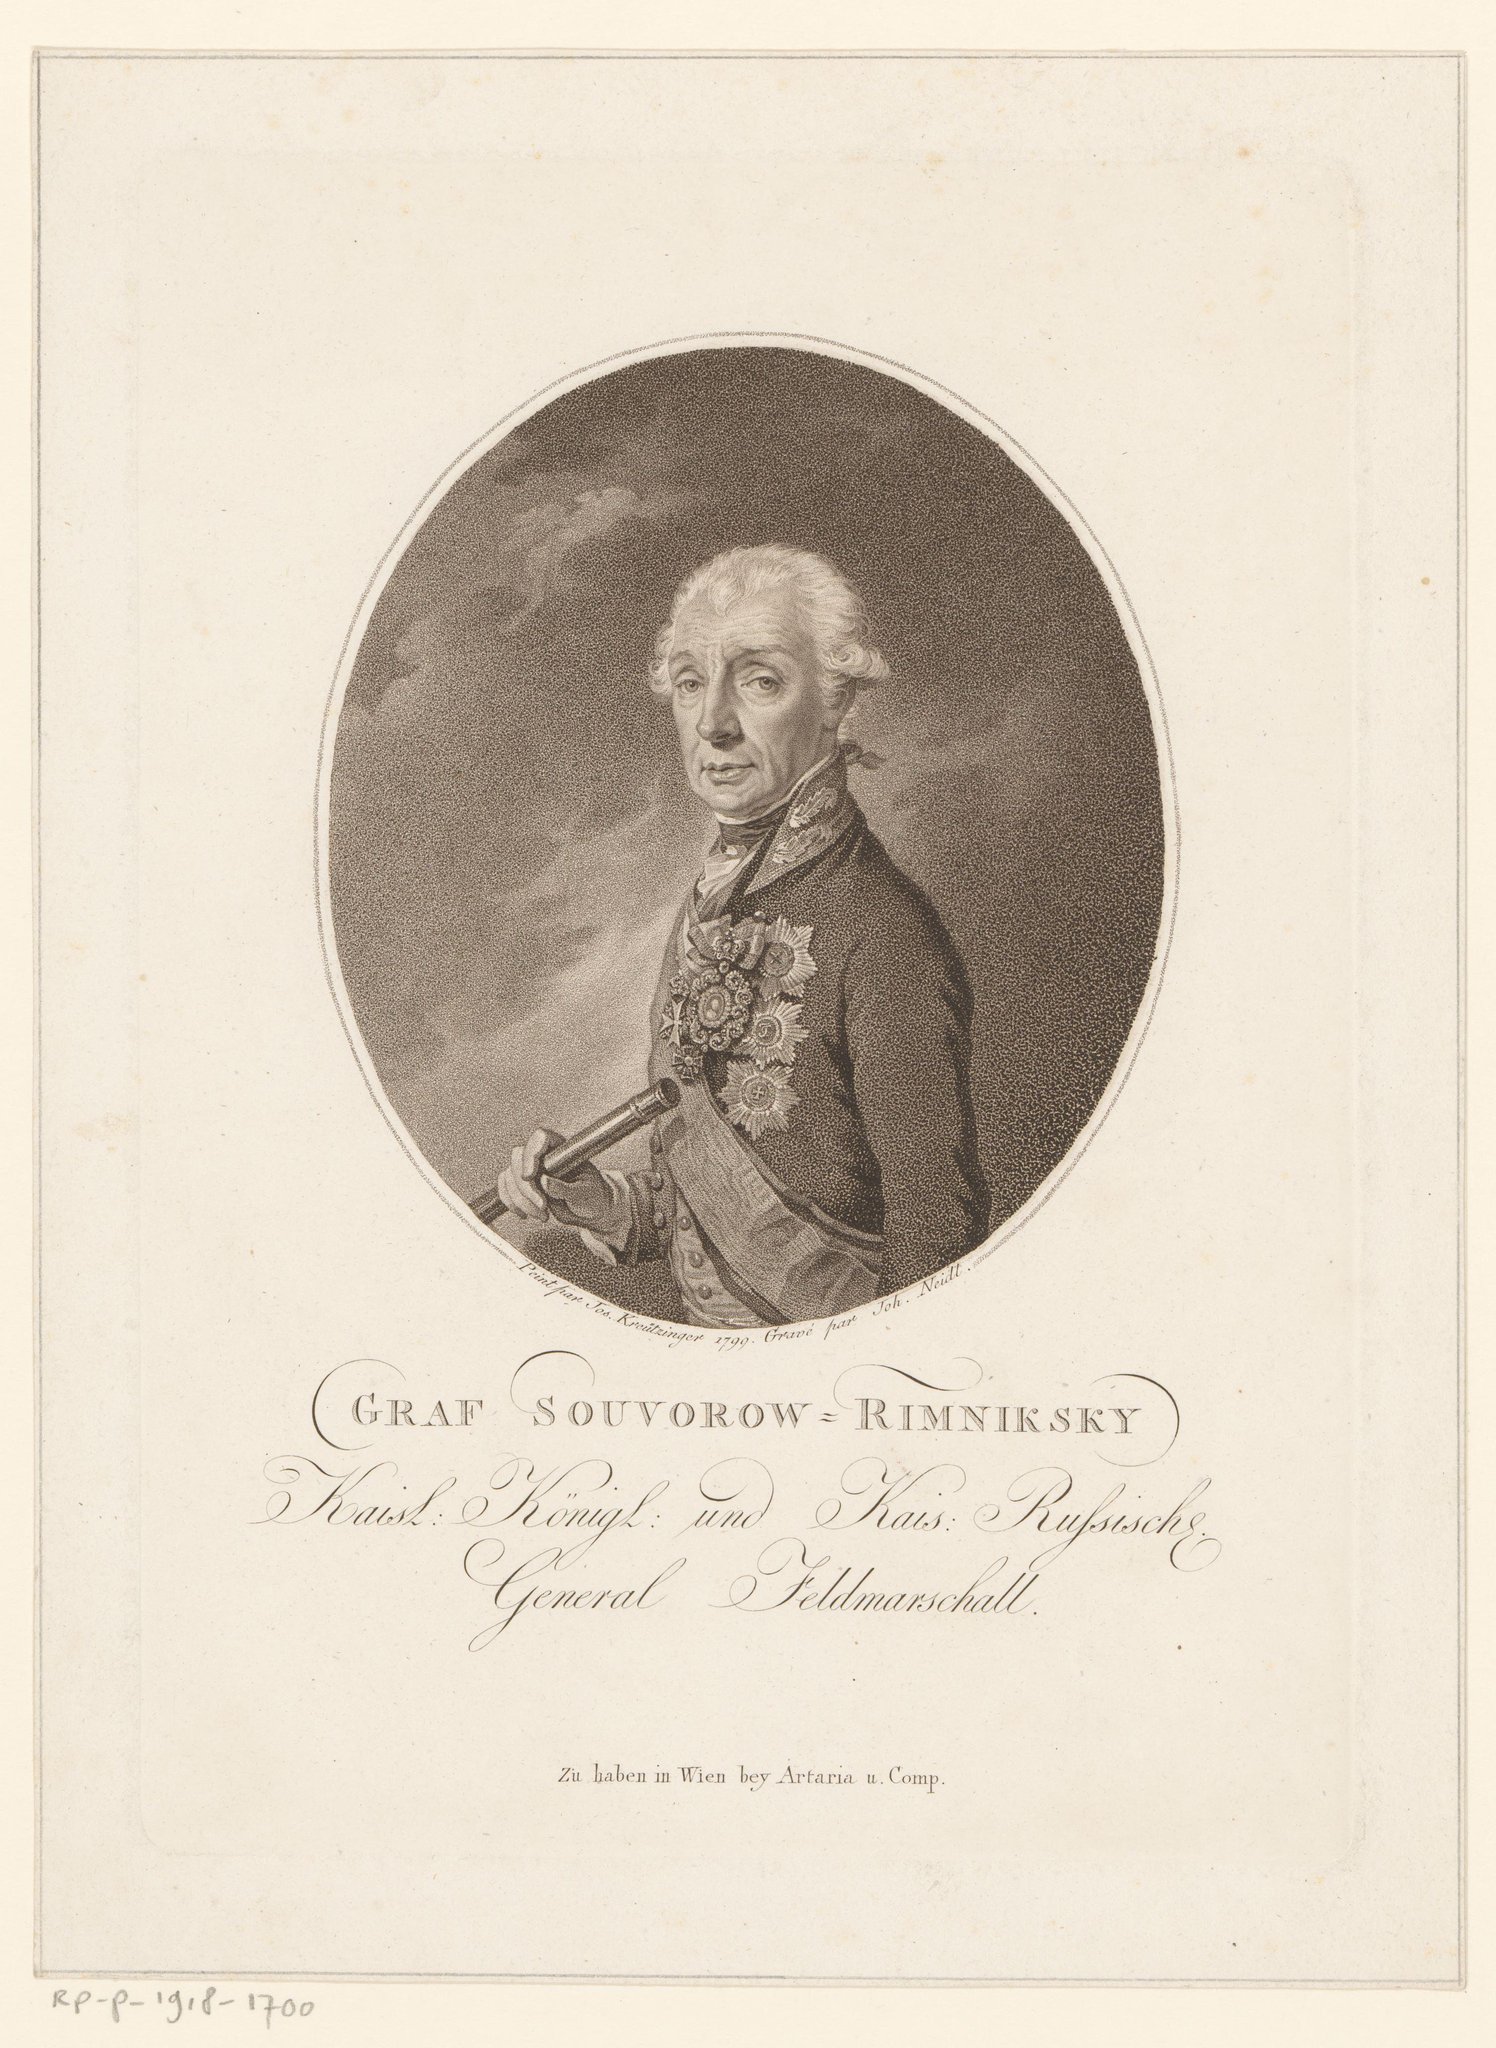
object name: print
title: Portret van Aleksandr Soevorov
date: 1799-1832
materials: paper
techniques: engraving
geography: vienna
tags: historical persons, medals and other marks of military honour, baton of general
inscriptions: collector's mark: Lugt 2233